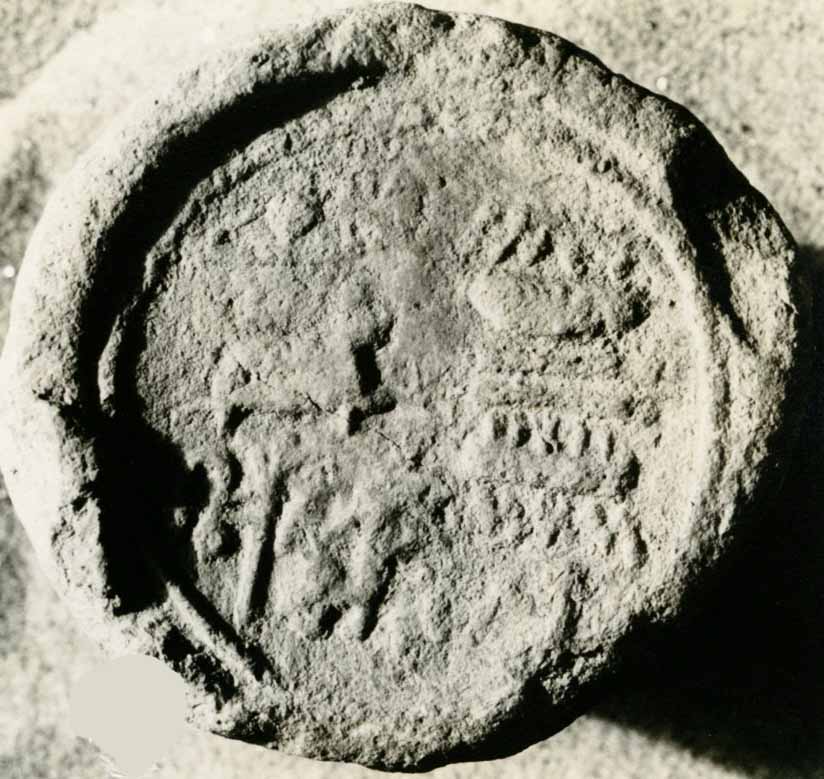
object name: cone, meny, chief scribe of amun, meryre, house mistress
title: Funerary Cone of Meny and His Wife Meryre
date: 1550-1295 BCE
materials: pottery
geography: egypt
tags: hieroglyphs